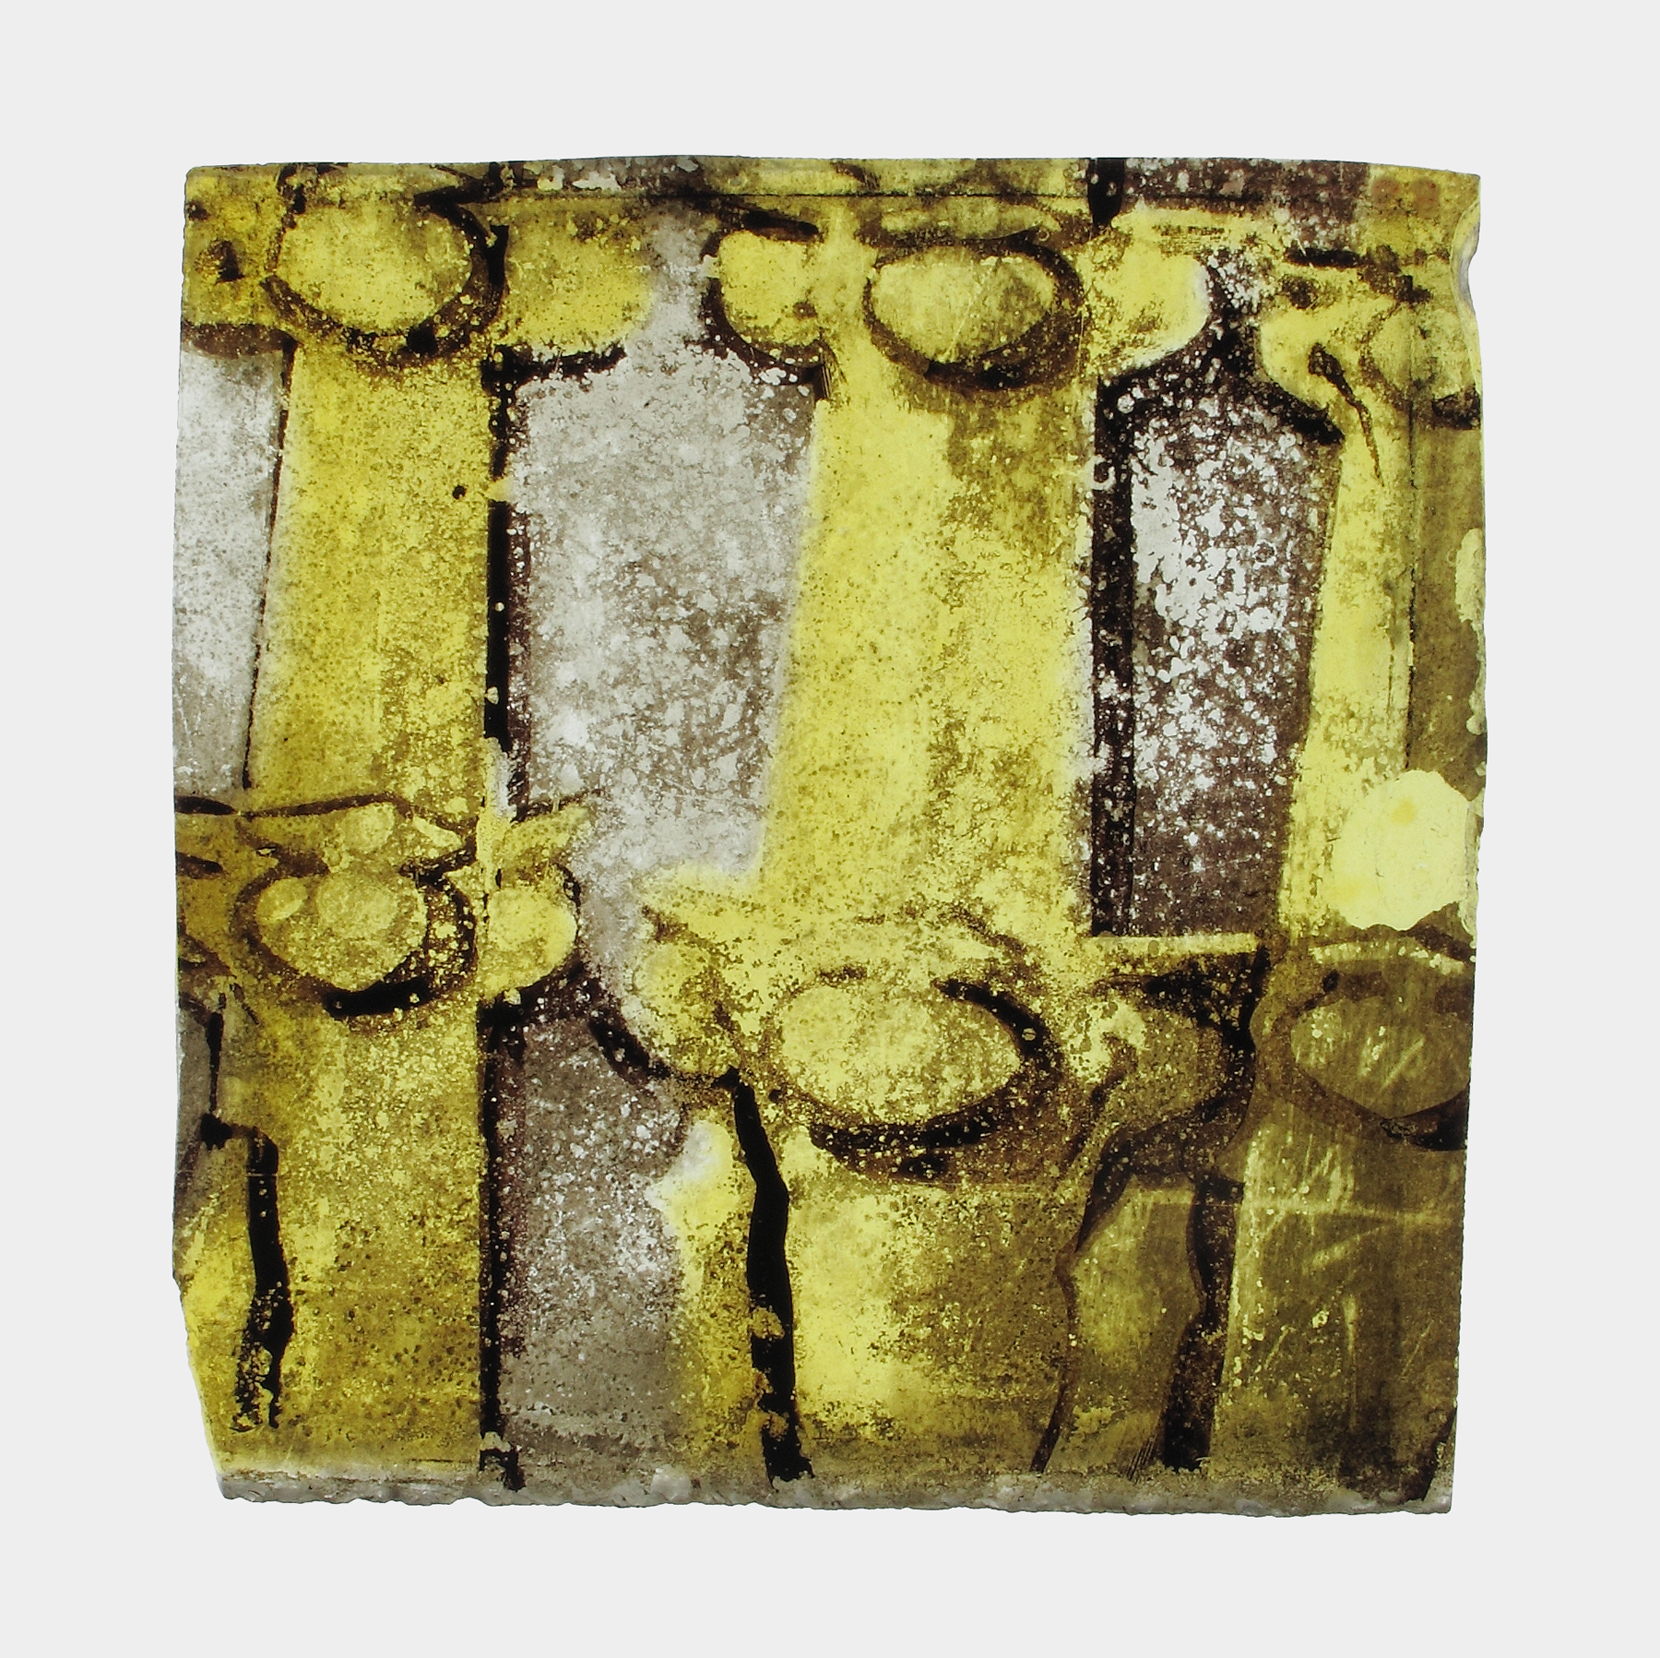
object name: fragment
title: Glass Fragment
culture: european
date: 1401-1500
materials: glass